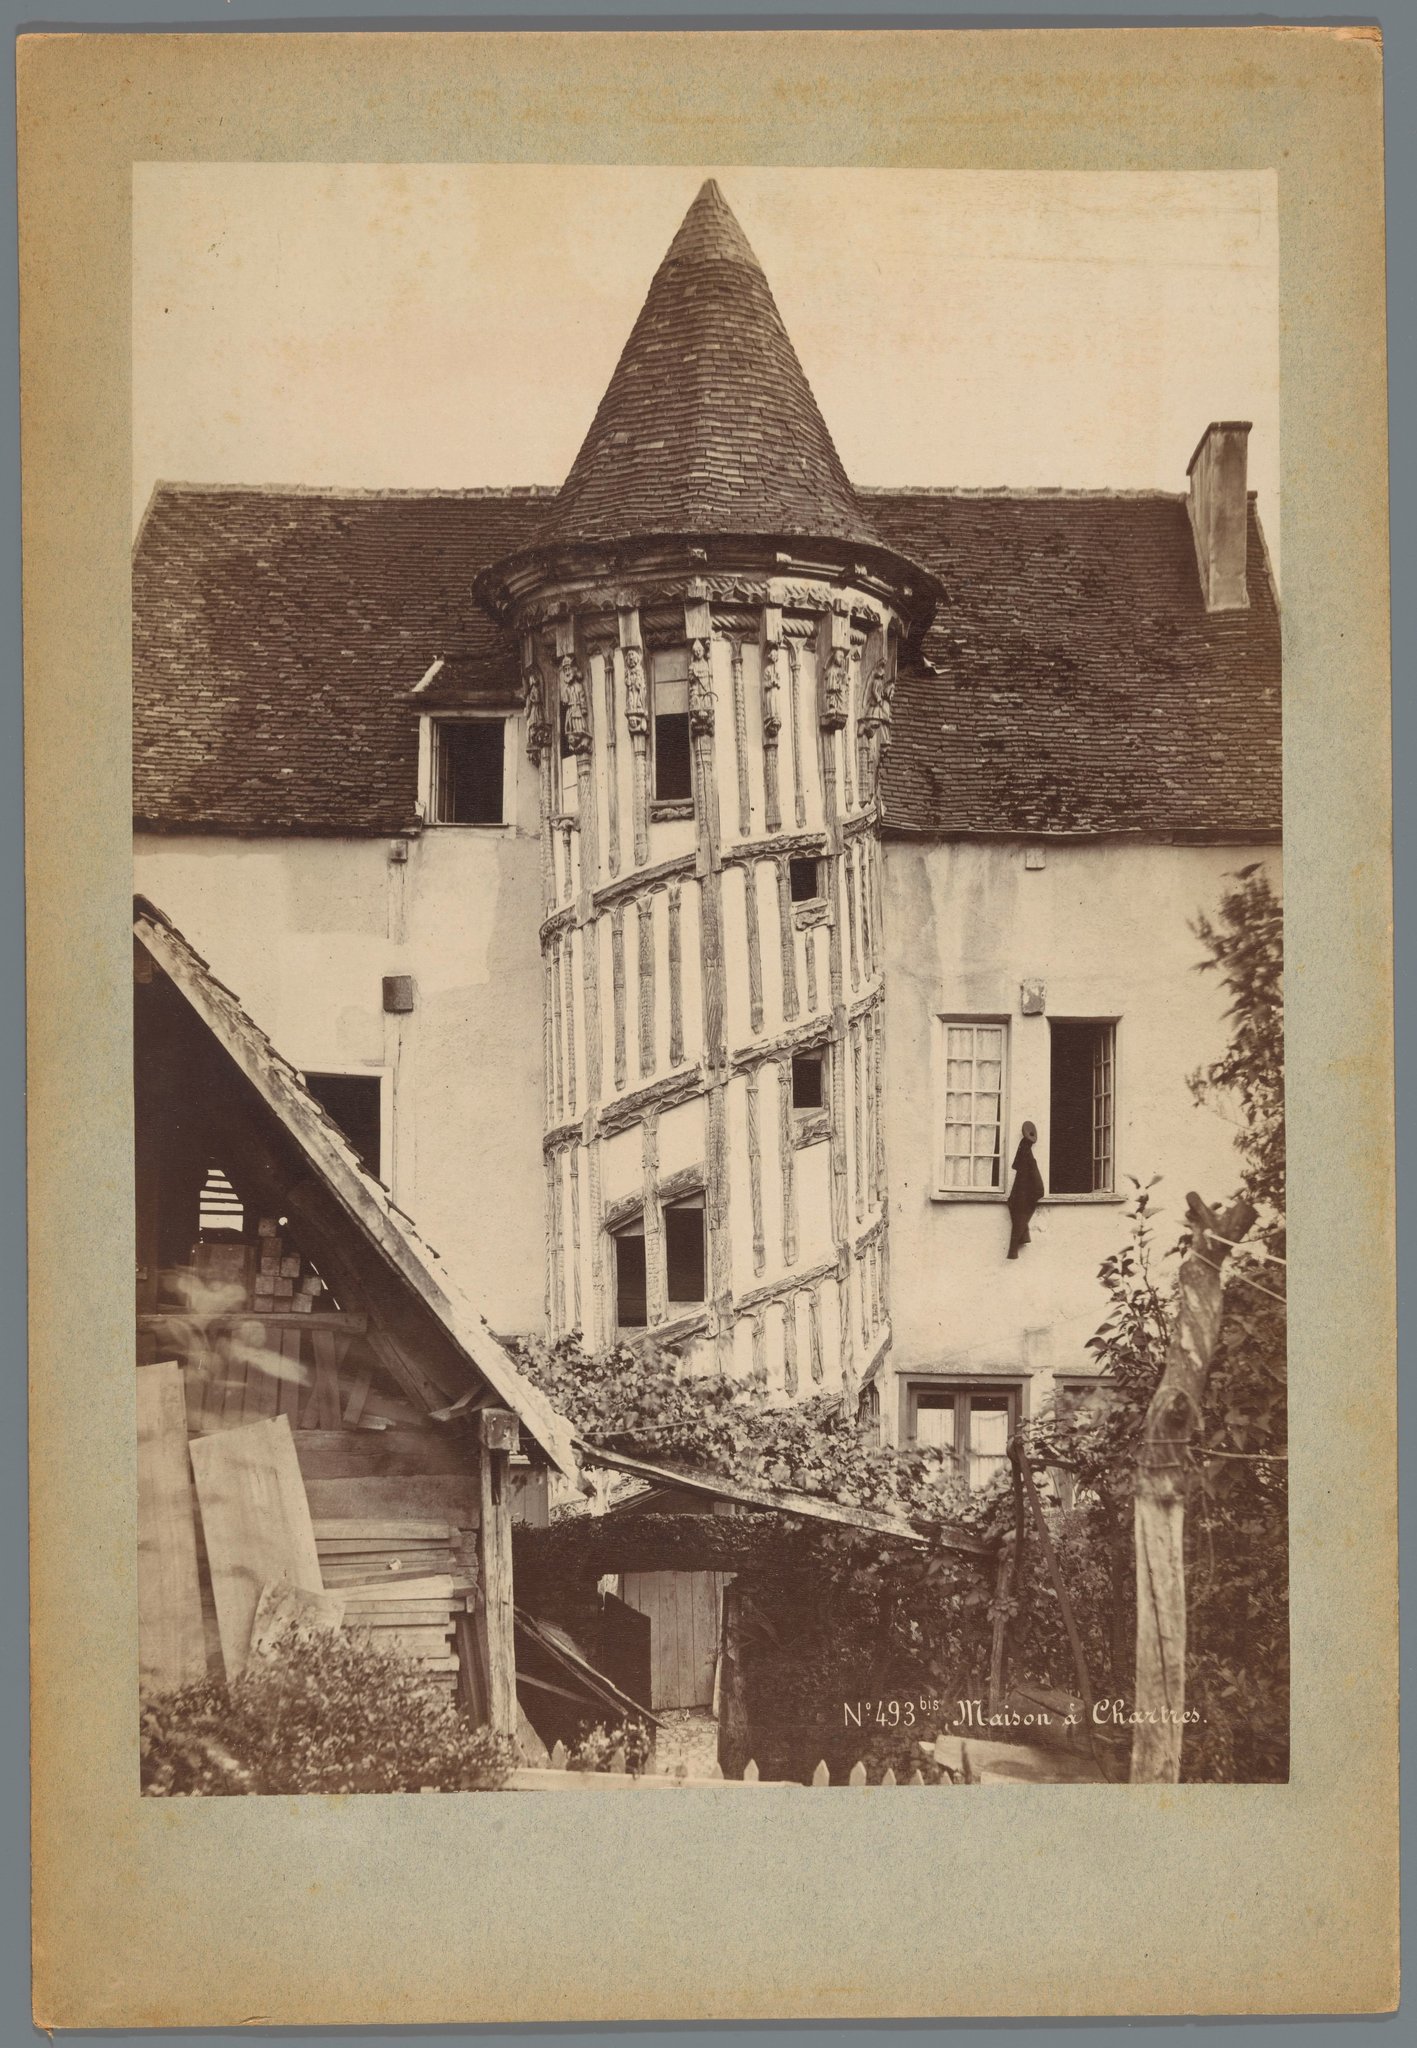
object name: photograph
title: Maison à Chartres.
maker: séraphin-médéric mieusement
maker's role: fotograaf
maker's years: 1840-1905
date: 1875-1900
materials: cardboard, photographic support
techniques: albumen print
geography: chartres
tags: timber framing, staircase, shed, façade (of house or building)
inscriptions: name: ‘MONUMENTS HISTORIQUES’, name: ‘MIEUSEMENT PHOTOGRAPHE’, name: ‘KUNSTBOEKHANDEL J. A. G. DE LEUR PHOTOGRAAF - UITGEVER Huigenspark, 40b. DEN HAAG’, number: ‘No. 493 bis.’, inscription: ‘X ki pl 1’, collector's mark: Lugt 3937